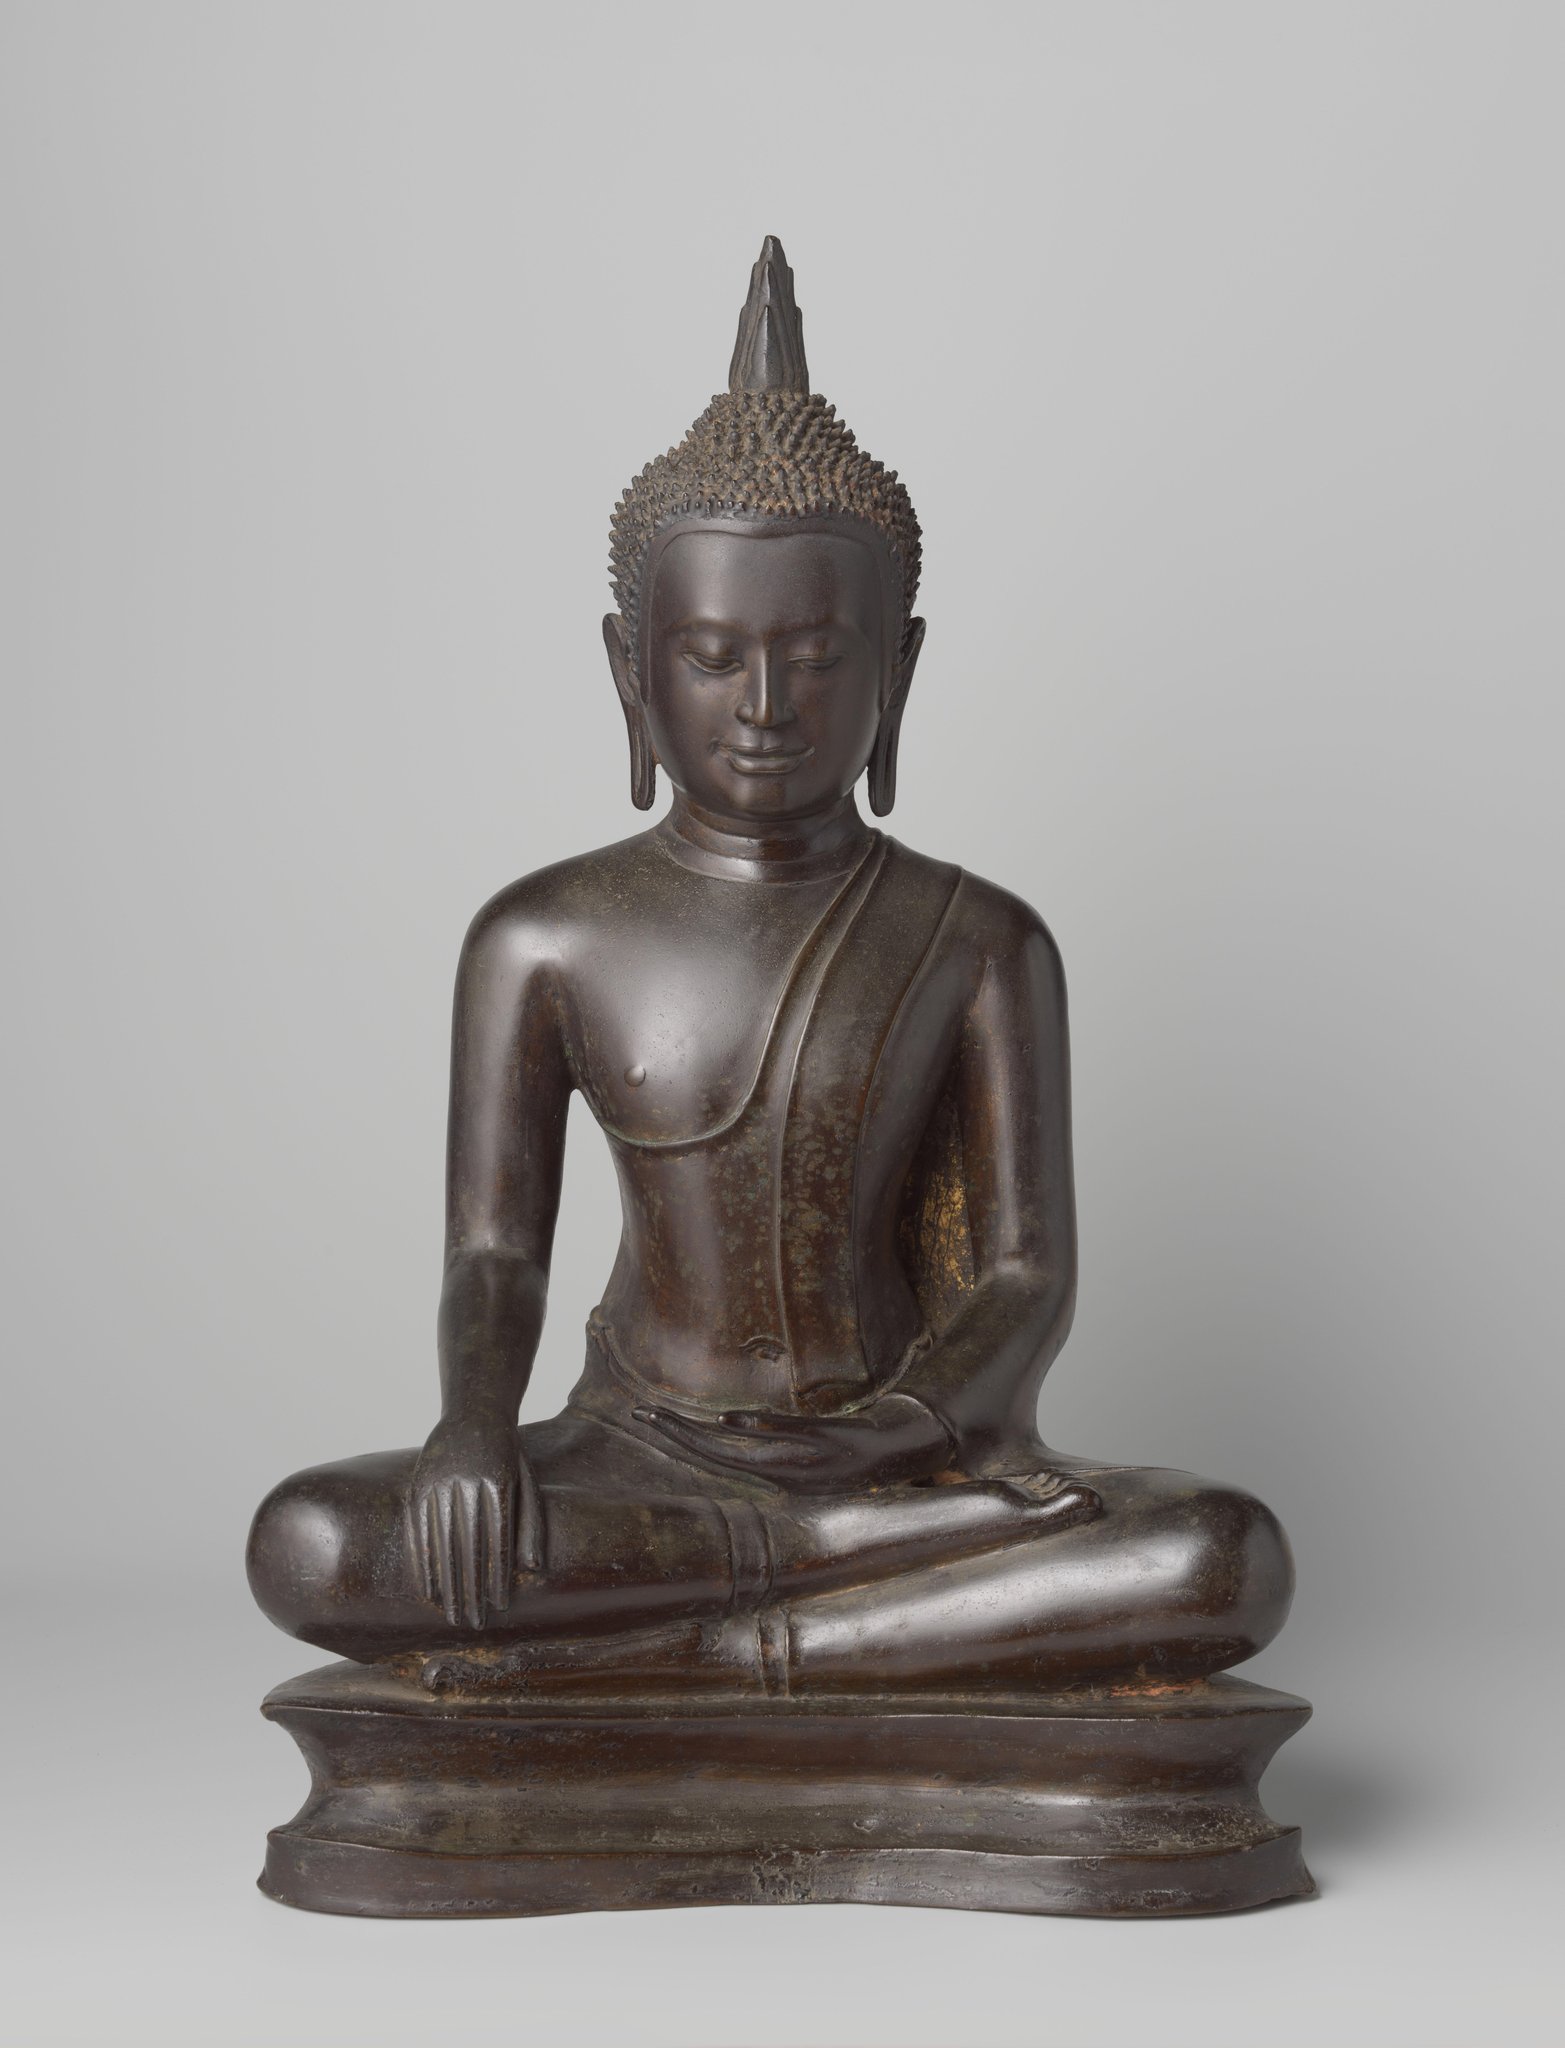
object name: boeddha kop, boeddha beeld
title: Buddha Sakyamuni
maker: Anonymous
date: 1300-1499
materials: bronze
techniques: casting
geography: thailand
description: The historical Buddha Sakyamuni is shown seated in the virasana position, with his right leg folded over the left. His left hand rests on his lap with the palm open and turned upwards, while his right hand is placed over his right leg near the knee with the fingers pointing down to the ground. This gesture is known as the bhumisparsa or maravijaya gesture and refers to the moment shortly before the Buddha's enlightenment. By gently touching the ground with his right hand, the Buddha calls the earth to be his witness (the meaning of 'bhumisparsa') and by this overcomes the powers of illusion ('maravijaya'). This type of Buddha image became increasingly popular from the 13th century CE onwards and is particularly associated with the Theravada Buddhist traditions of Myanmar and Thailand. The Buddha wears a monk’s robe over his left shoulder, leaving the right shoulder bare. An undergarment is clearly visible at the waist and an additional sash is placed over the left shoulder. The Buddha's hair consists of a mass of tight curls kept in place by a plain hairband across the brow. A low protuberance on the top of the head (usnisa) is also covered in hair curls and topped by a stylised flame motif. This hair form, the naturalistic proportions of the body, the delineation of the face and the simple, indented form of the base are all typical of the U Thong B style of Buddha images from Central Thailand and can be dated to the early Ayuthaya period of the 14th to 15th centuries CE.